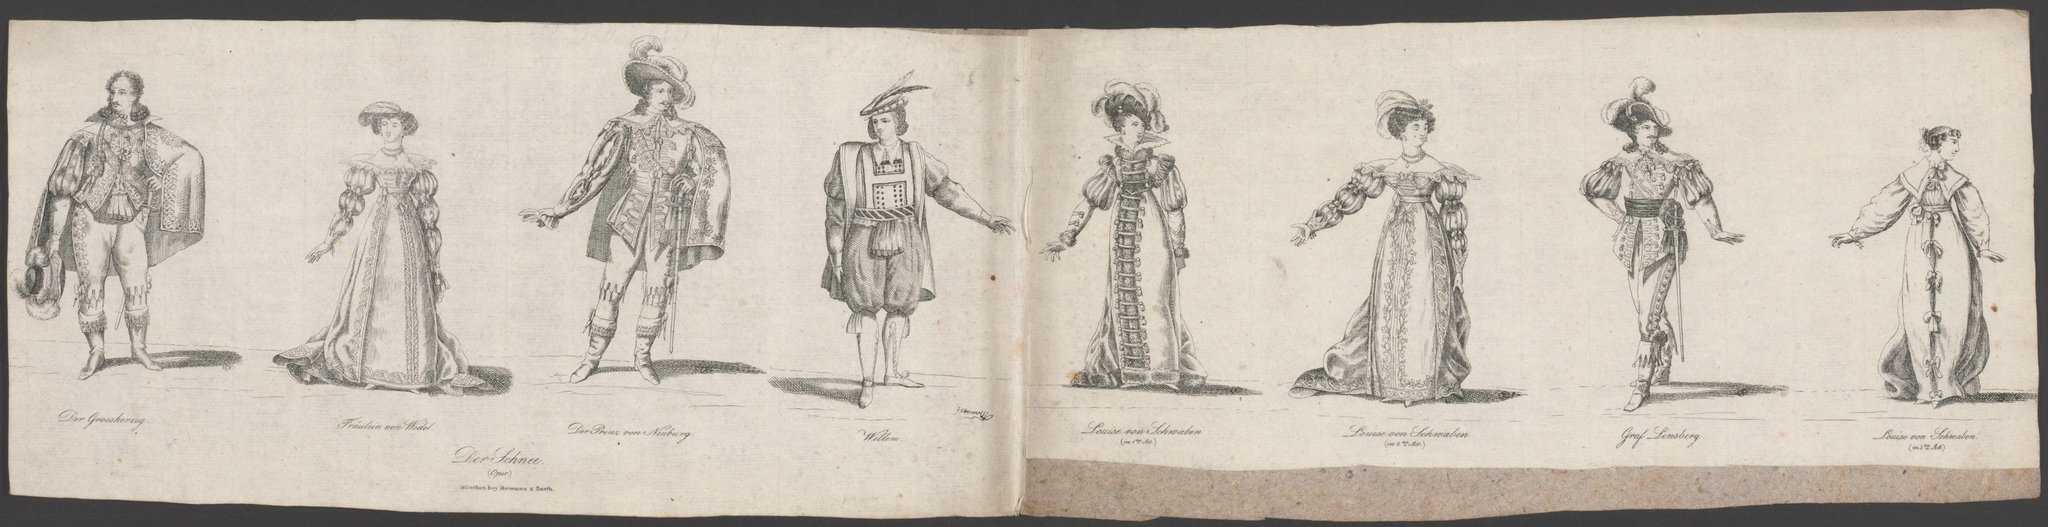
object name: print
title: Kostuums van de opera La Neige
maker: peter ellmer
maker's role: draughtsman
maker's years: 1793-1872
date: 1750-1865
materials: paper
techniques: lithograph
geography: munich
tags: stage costume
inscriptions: collector's mark: Lugt 1641, stamp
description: Twee prenten van kostuums van de opera La Neige. Onderwerpsrubrieken binnen de Atlas Zeden en Gewoonten: Zeden en gewoonten in engeren zin, Des menschen begin, midden en einde, Kinderprenten opgeplakt op karton.